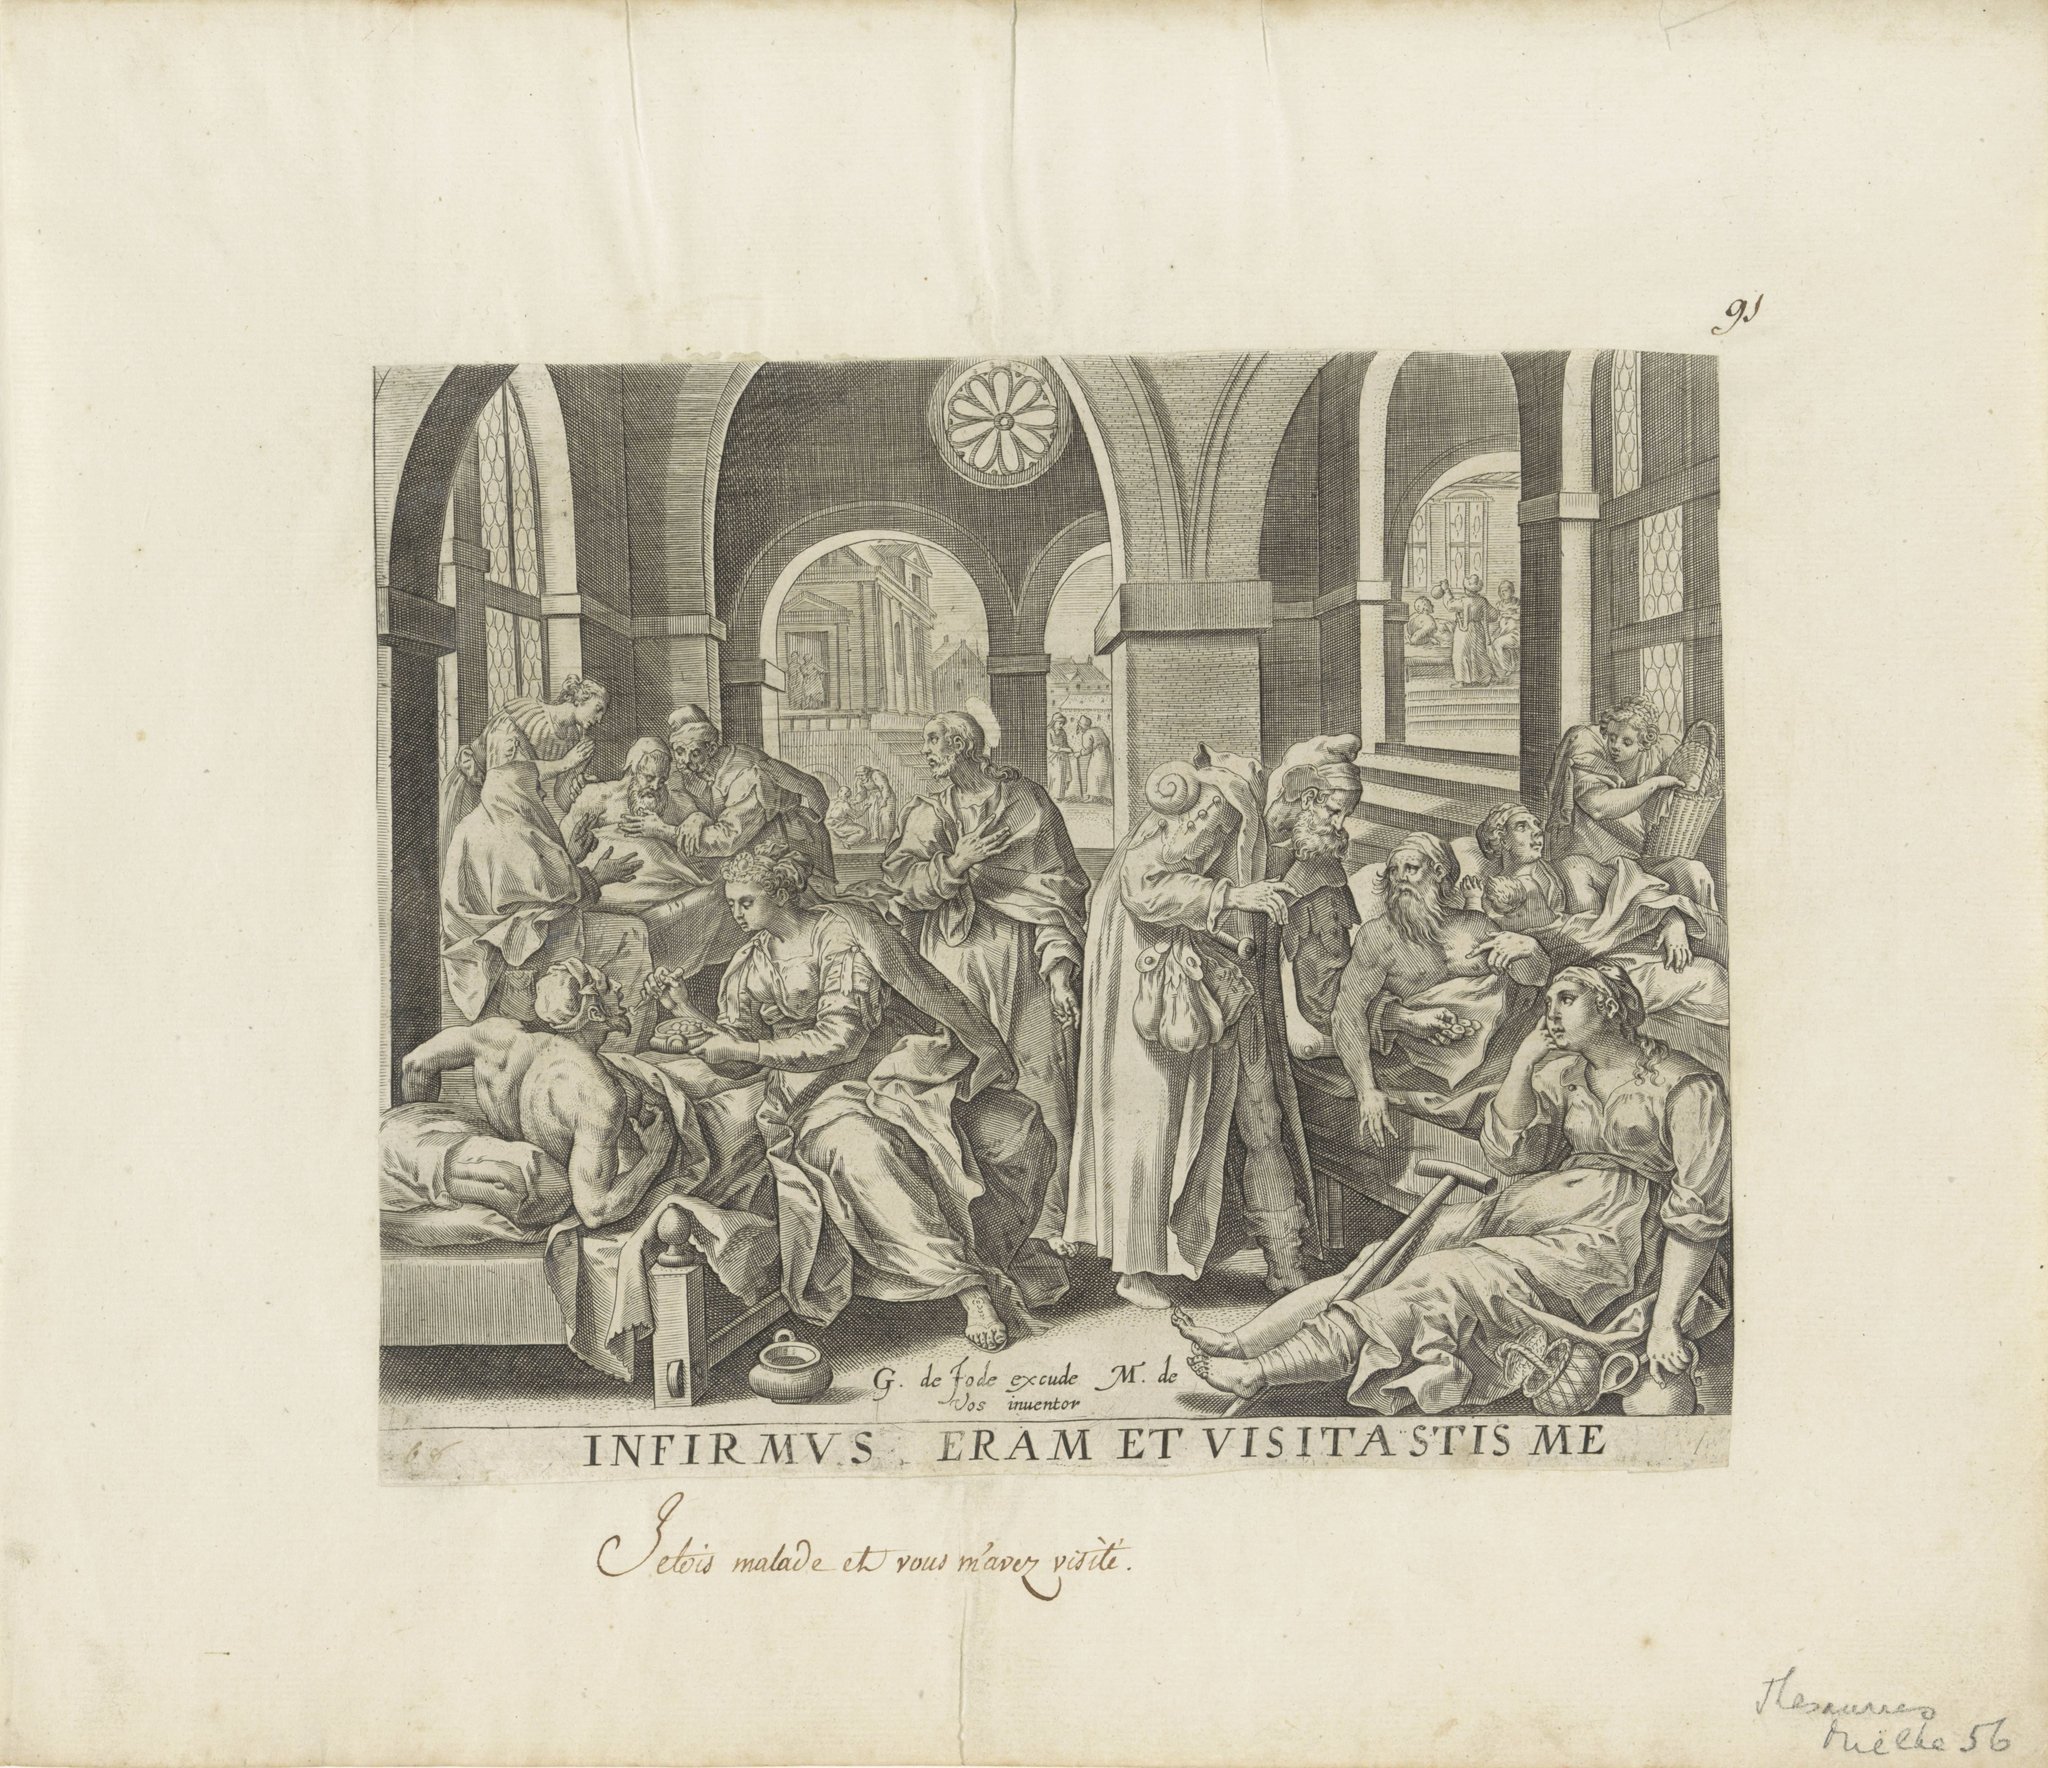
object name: print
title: Bezoeken van de zieken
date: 1585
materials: paper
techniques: engraving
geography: antwerp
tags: visiting the sick, 'aeger curatur' ~ one of the (seven) acts of mercy - vv - christ present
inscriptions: number: ‘91’, inscription: ‘J'etois malade et vous m'avez visité.’, collector's mark: Lugt 2228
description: In een hospitaal verzorgen mensen de zieken. Links geeft een vrouw een man te eten. Rechts geeft een man wat geld weg. Christus staat in het midden van de ruimte. Onder de voorstelling een verwijzing in het Latijn naar de Bijbeltekst.